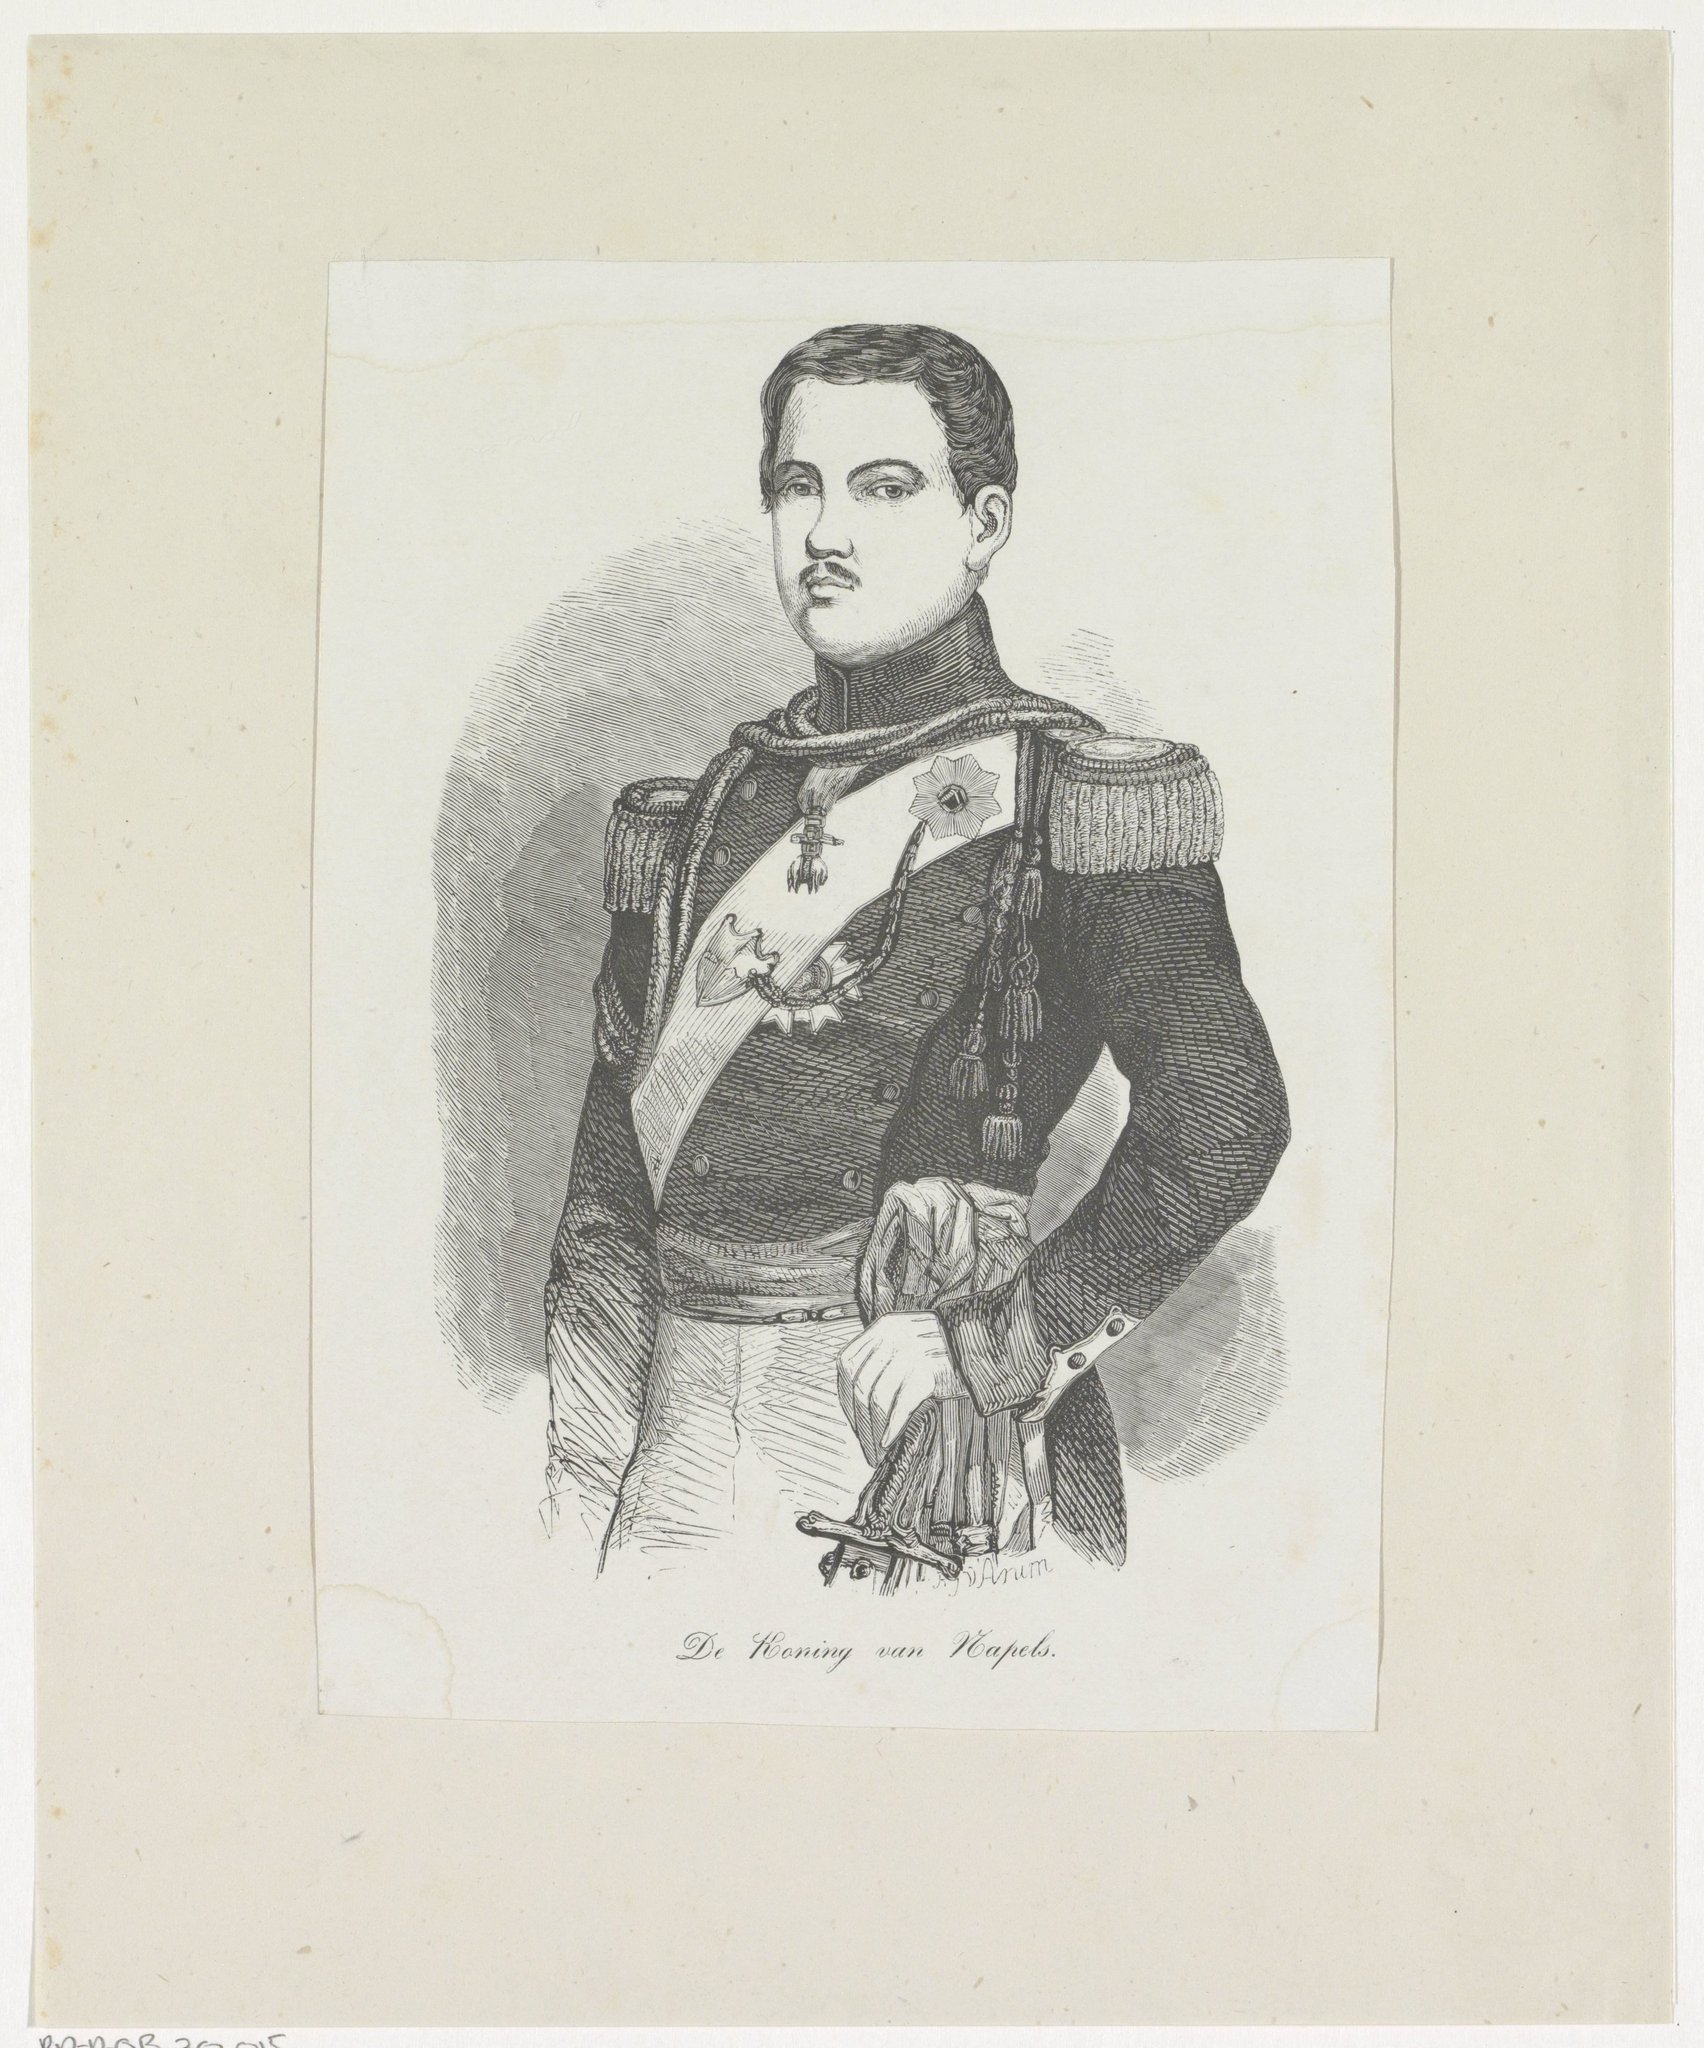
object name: print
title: Portret van een koning van Napels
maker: rombertus julianus van arum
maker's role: print maker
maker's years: 1812-1883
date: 1822-1883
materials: paper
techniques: engraving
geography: amsterdam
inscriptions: collector's mark: Lugt 2228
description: Portret van een koning van Napels. In de ondermarge zijn titel.